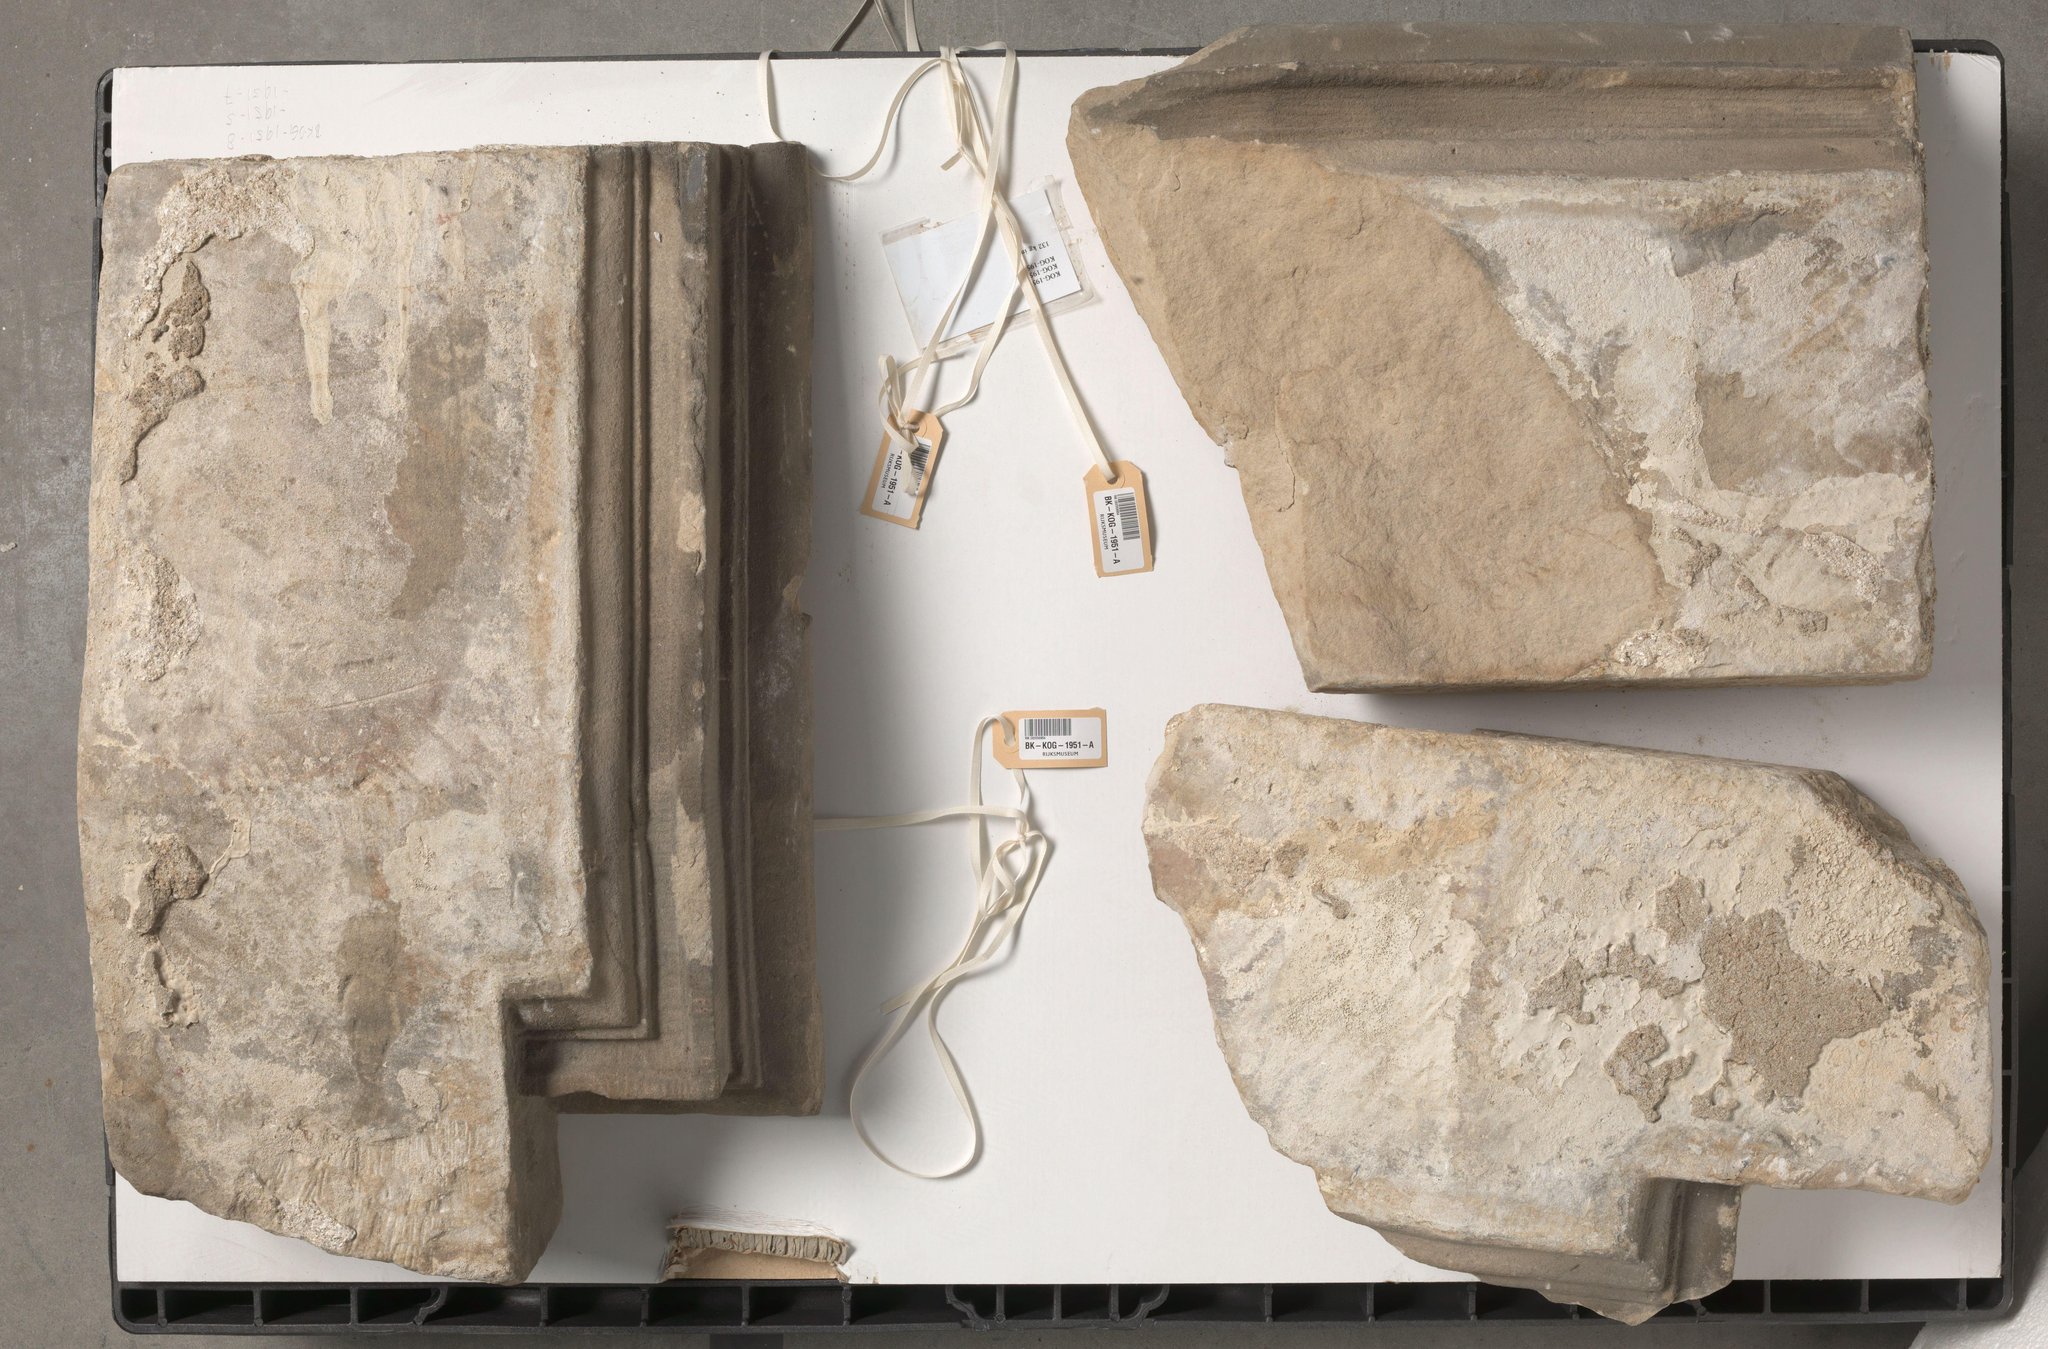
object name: architectural element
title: Onderdelen van een poort van zandsteen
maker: Anonymous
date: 1400-1950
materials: stone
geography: amsterdam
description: Onderdelen horend bij een poort van "Het huis te Groesbeek", Amsterdam, bewoond door Dr. J.A. Alberdingk Thijm. Het betreft onderdelen met de nummers BK-KOG-1951-5, BK-KOG-1951-7 en BK-KOG-1951-8.